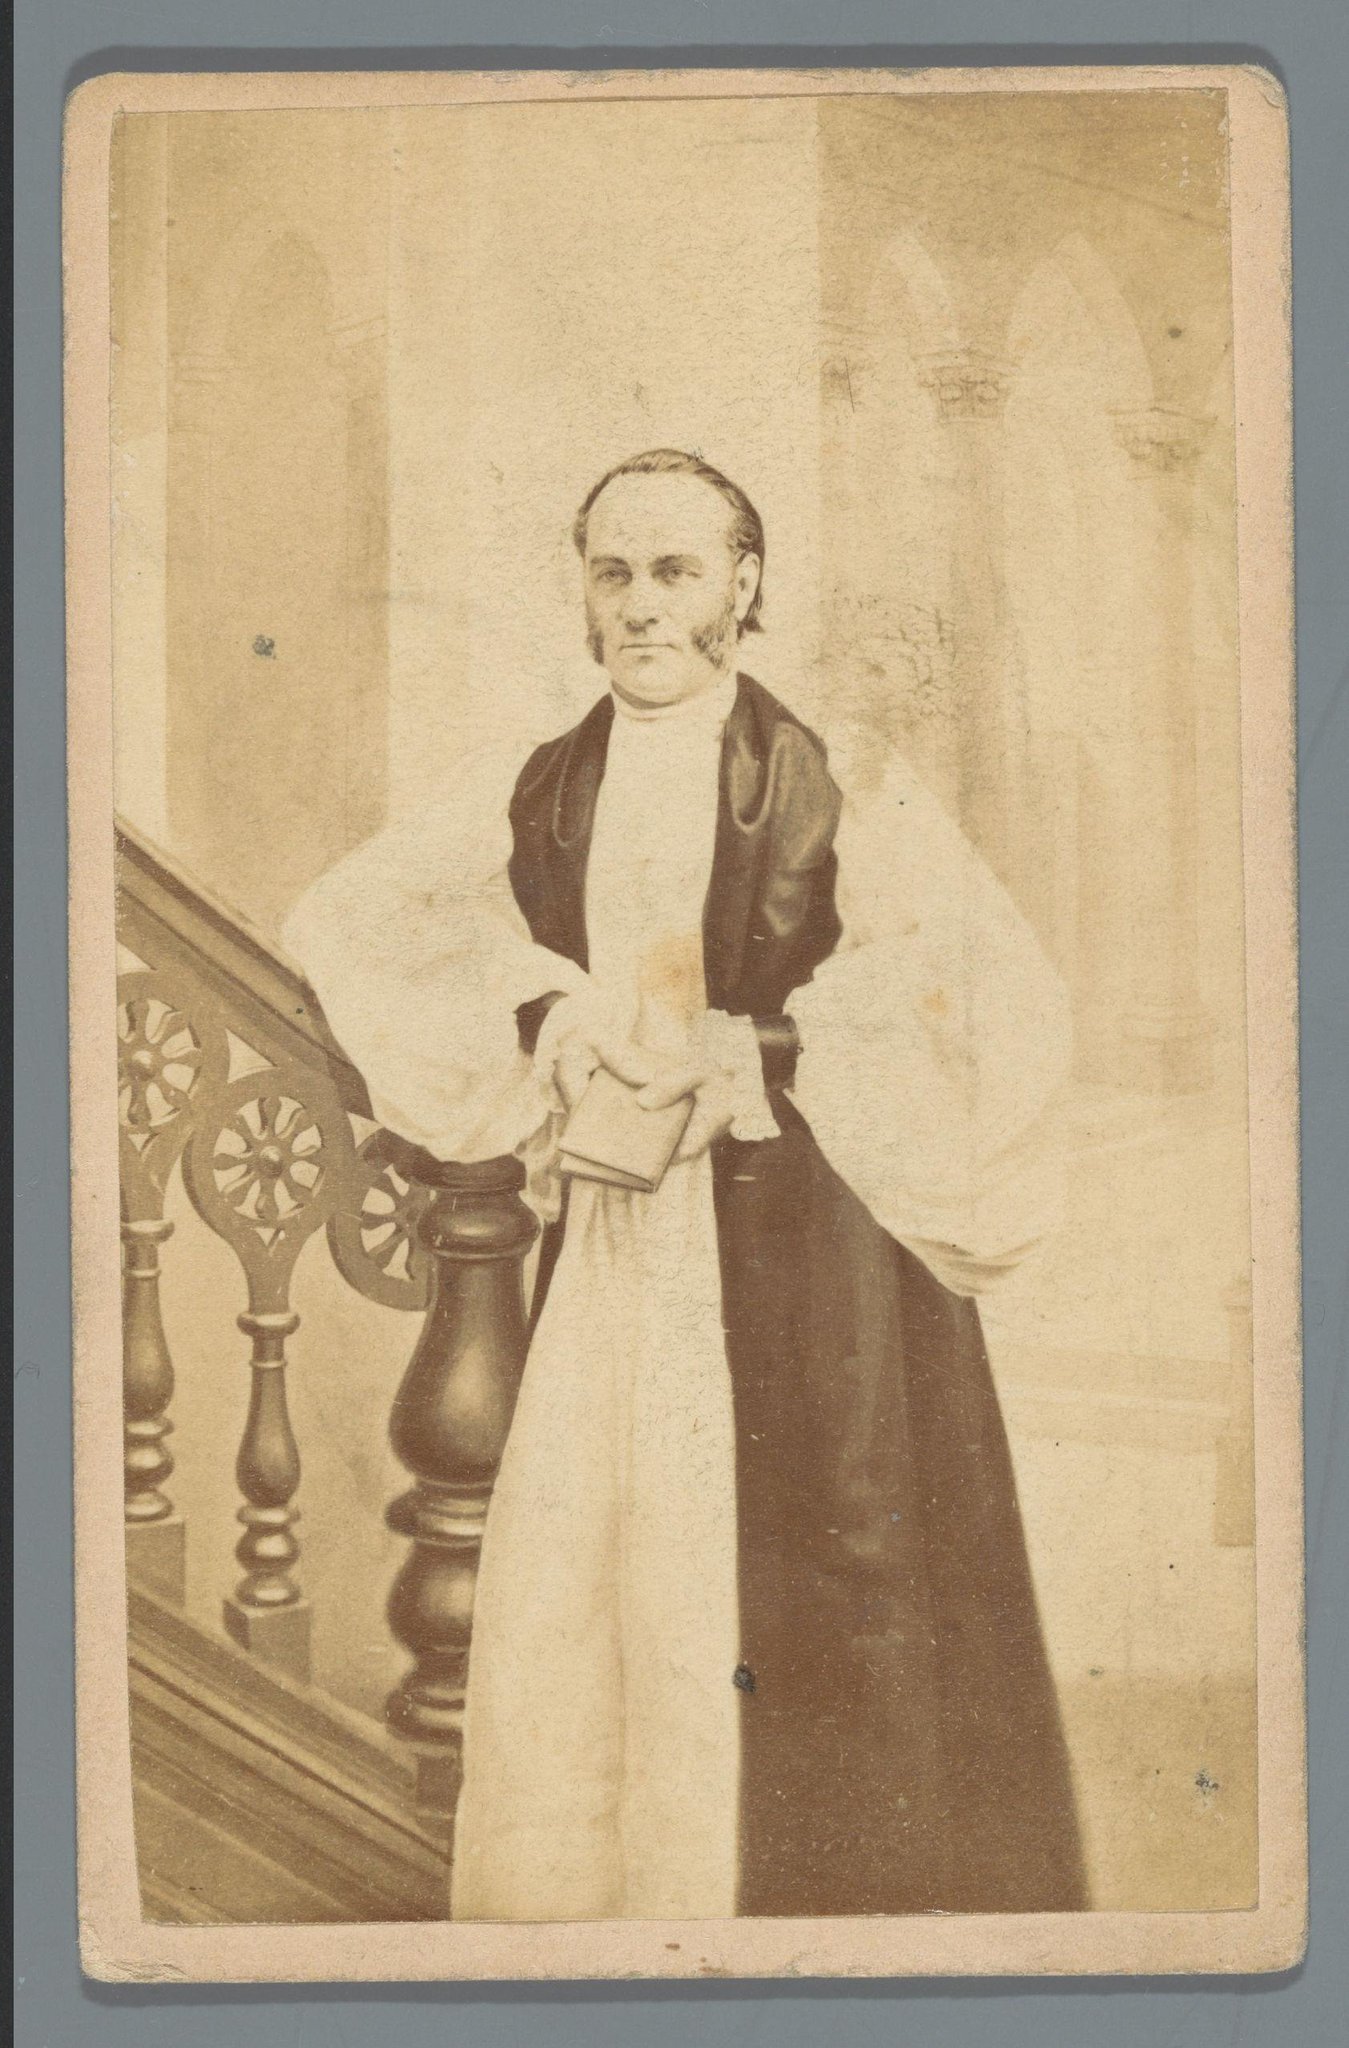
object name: reproduction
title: Fotoreproductie van een portret van een onbekende geestelijke in een kerkinterieur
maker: Anonymous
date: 1855-1885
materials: cardboard, paper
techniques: albumen print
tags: interior of church, regular clerics, e.g. jesuits, redemptorists, anonymous historical person portrayed